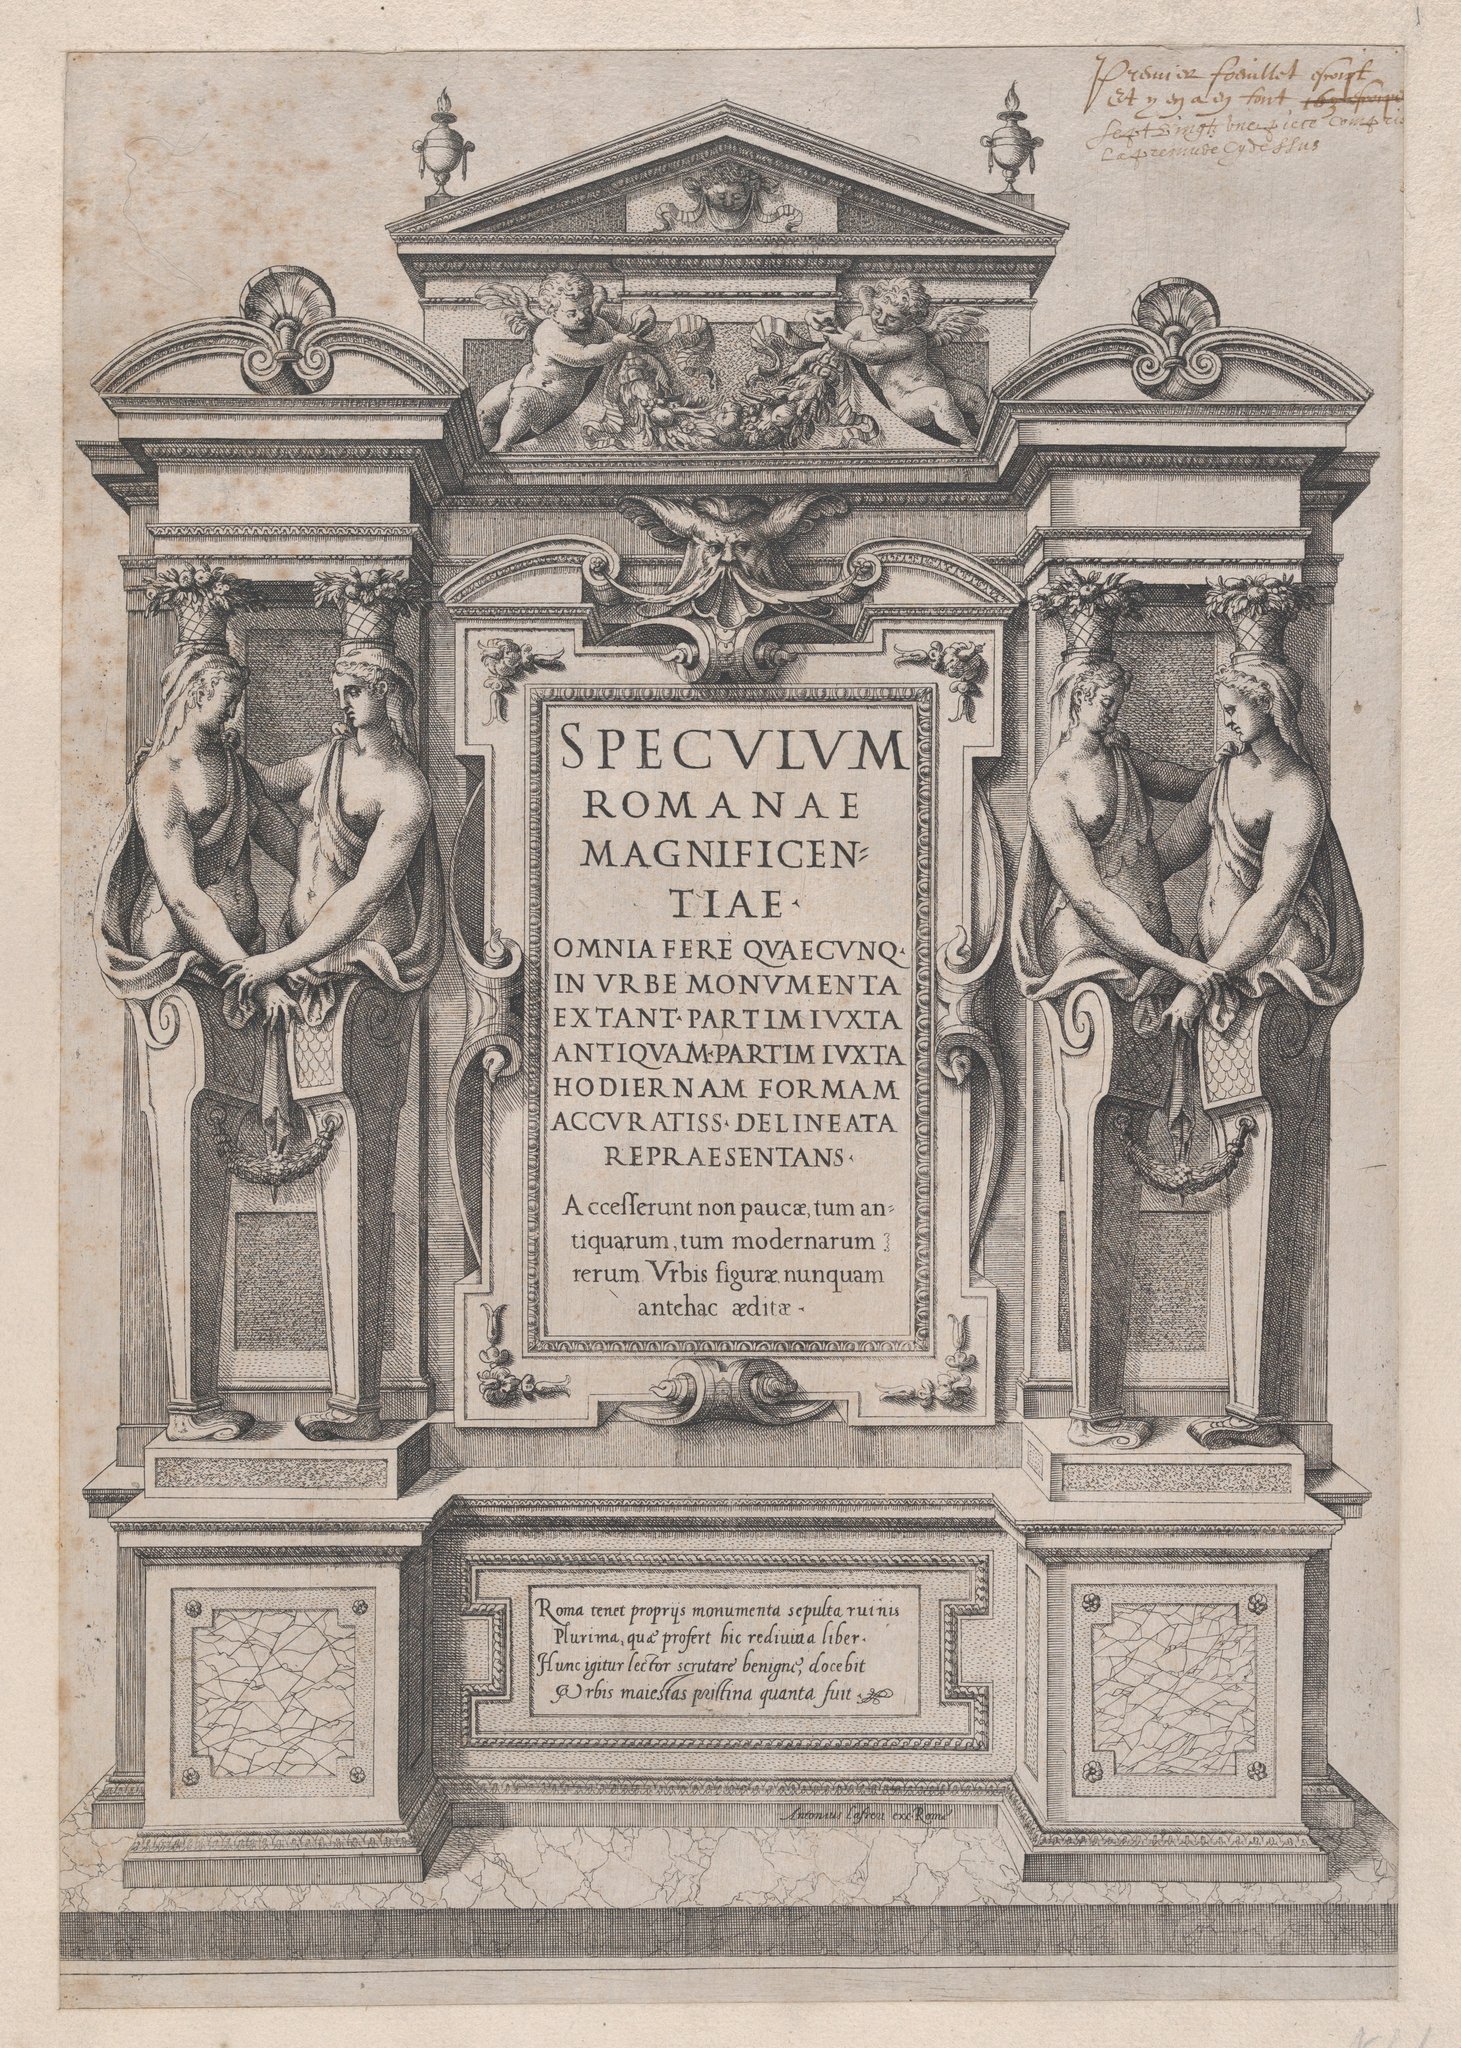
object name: print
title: Title page engraved within architectonic and sculptural border, from "Speculum Romanae Magnificentiae"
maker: etienne dupérac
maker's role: artist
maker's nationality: french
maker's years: 1535-1604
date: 1573-1577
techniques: engraving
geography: rome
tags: sculpture